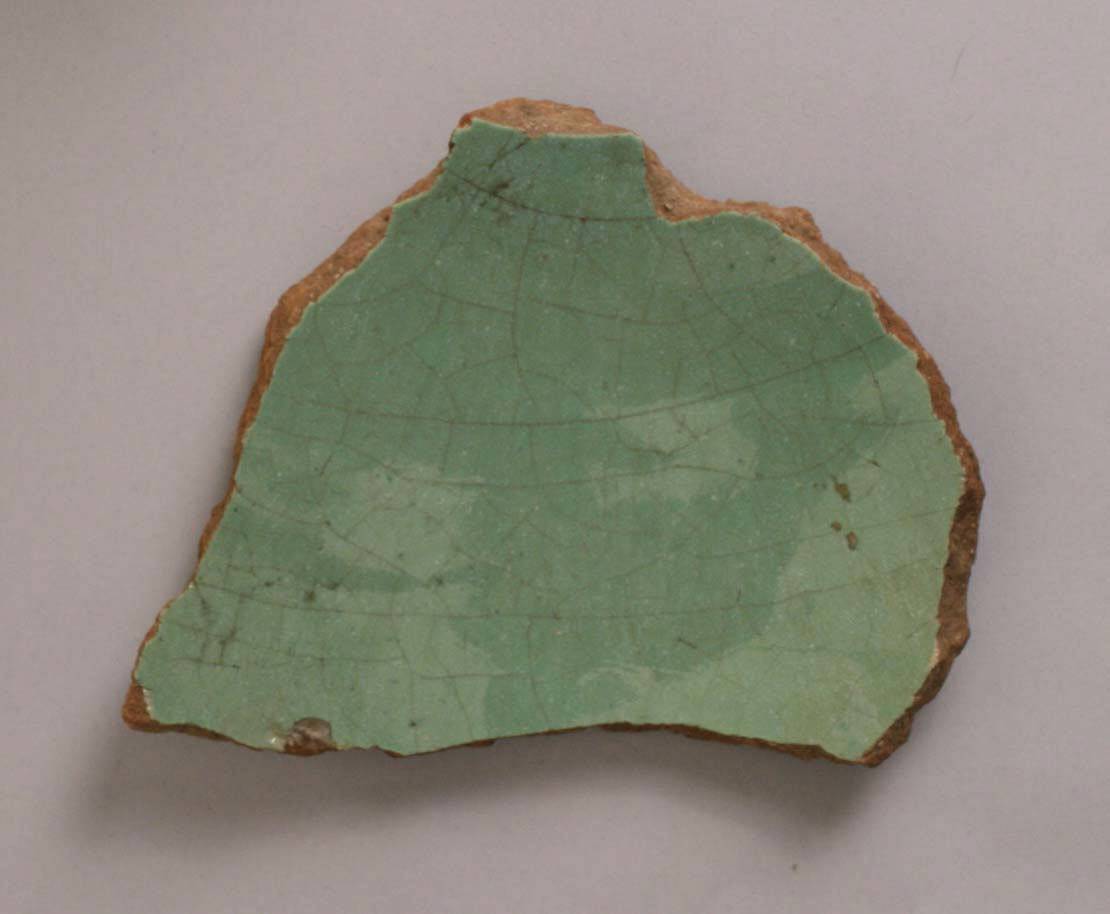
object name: fragment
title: Ceramic Fragment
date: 1201-1400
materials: earthenware, glaze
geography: egypt